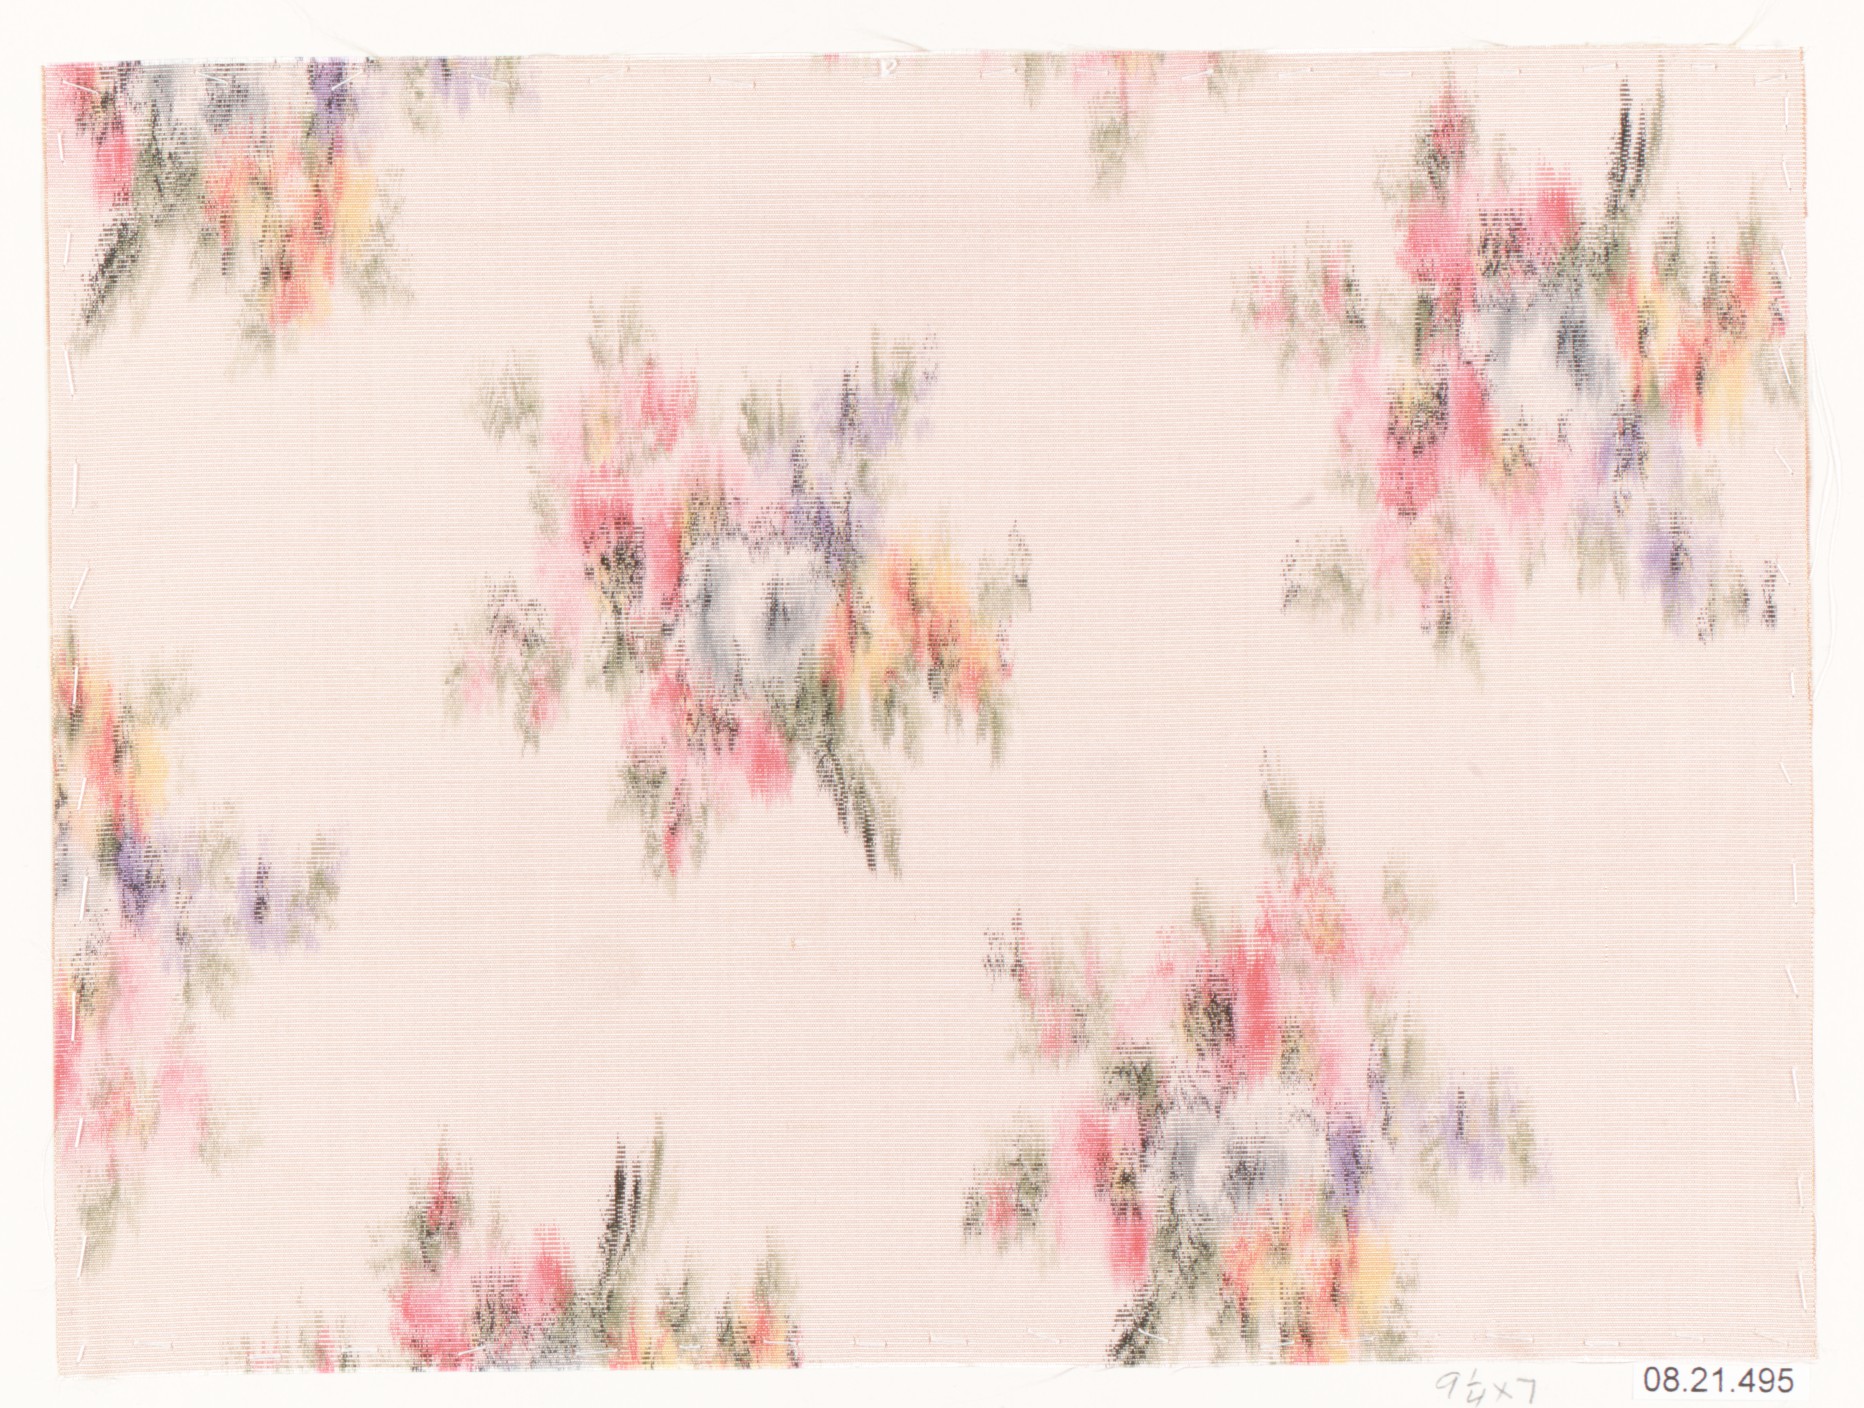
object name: textile sample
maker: Anonymous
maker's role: designer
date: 1900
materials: silk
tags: flowers